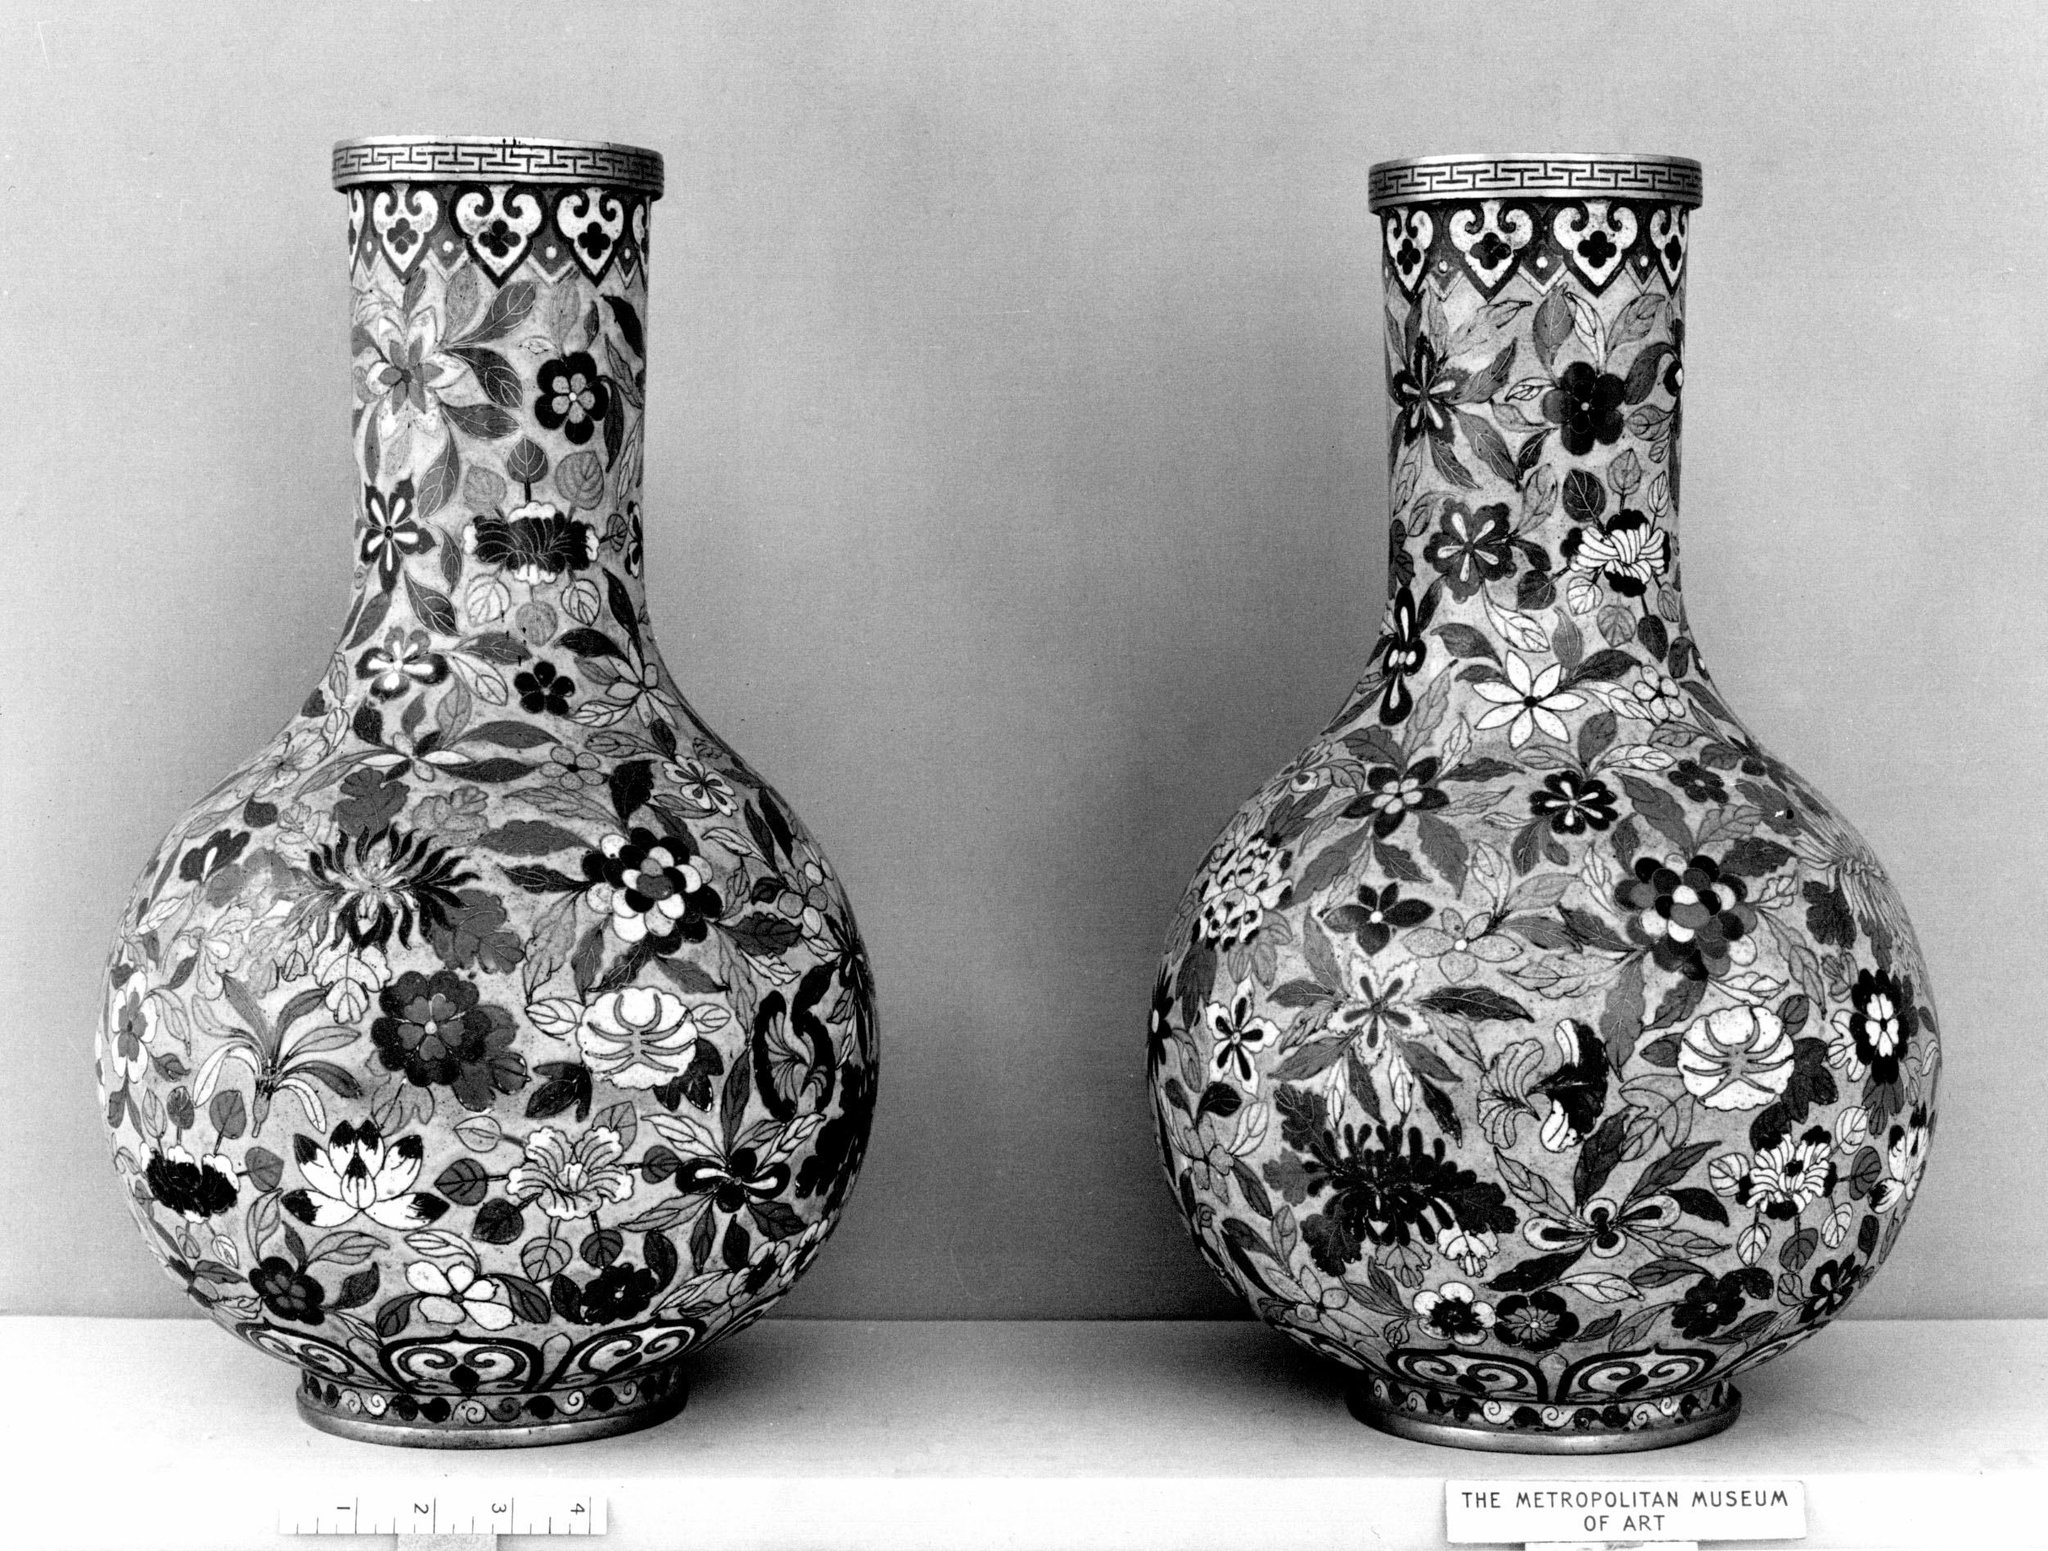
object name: vase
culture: chinese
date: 1801-1900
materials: enamel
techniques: enamel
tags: flowers,leaves